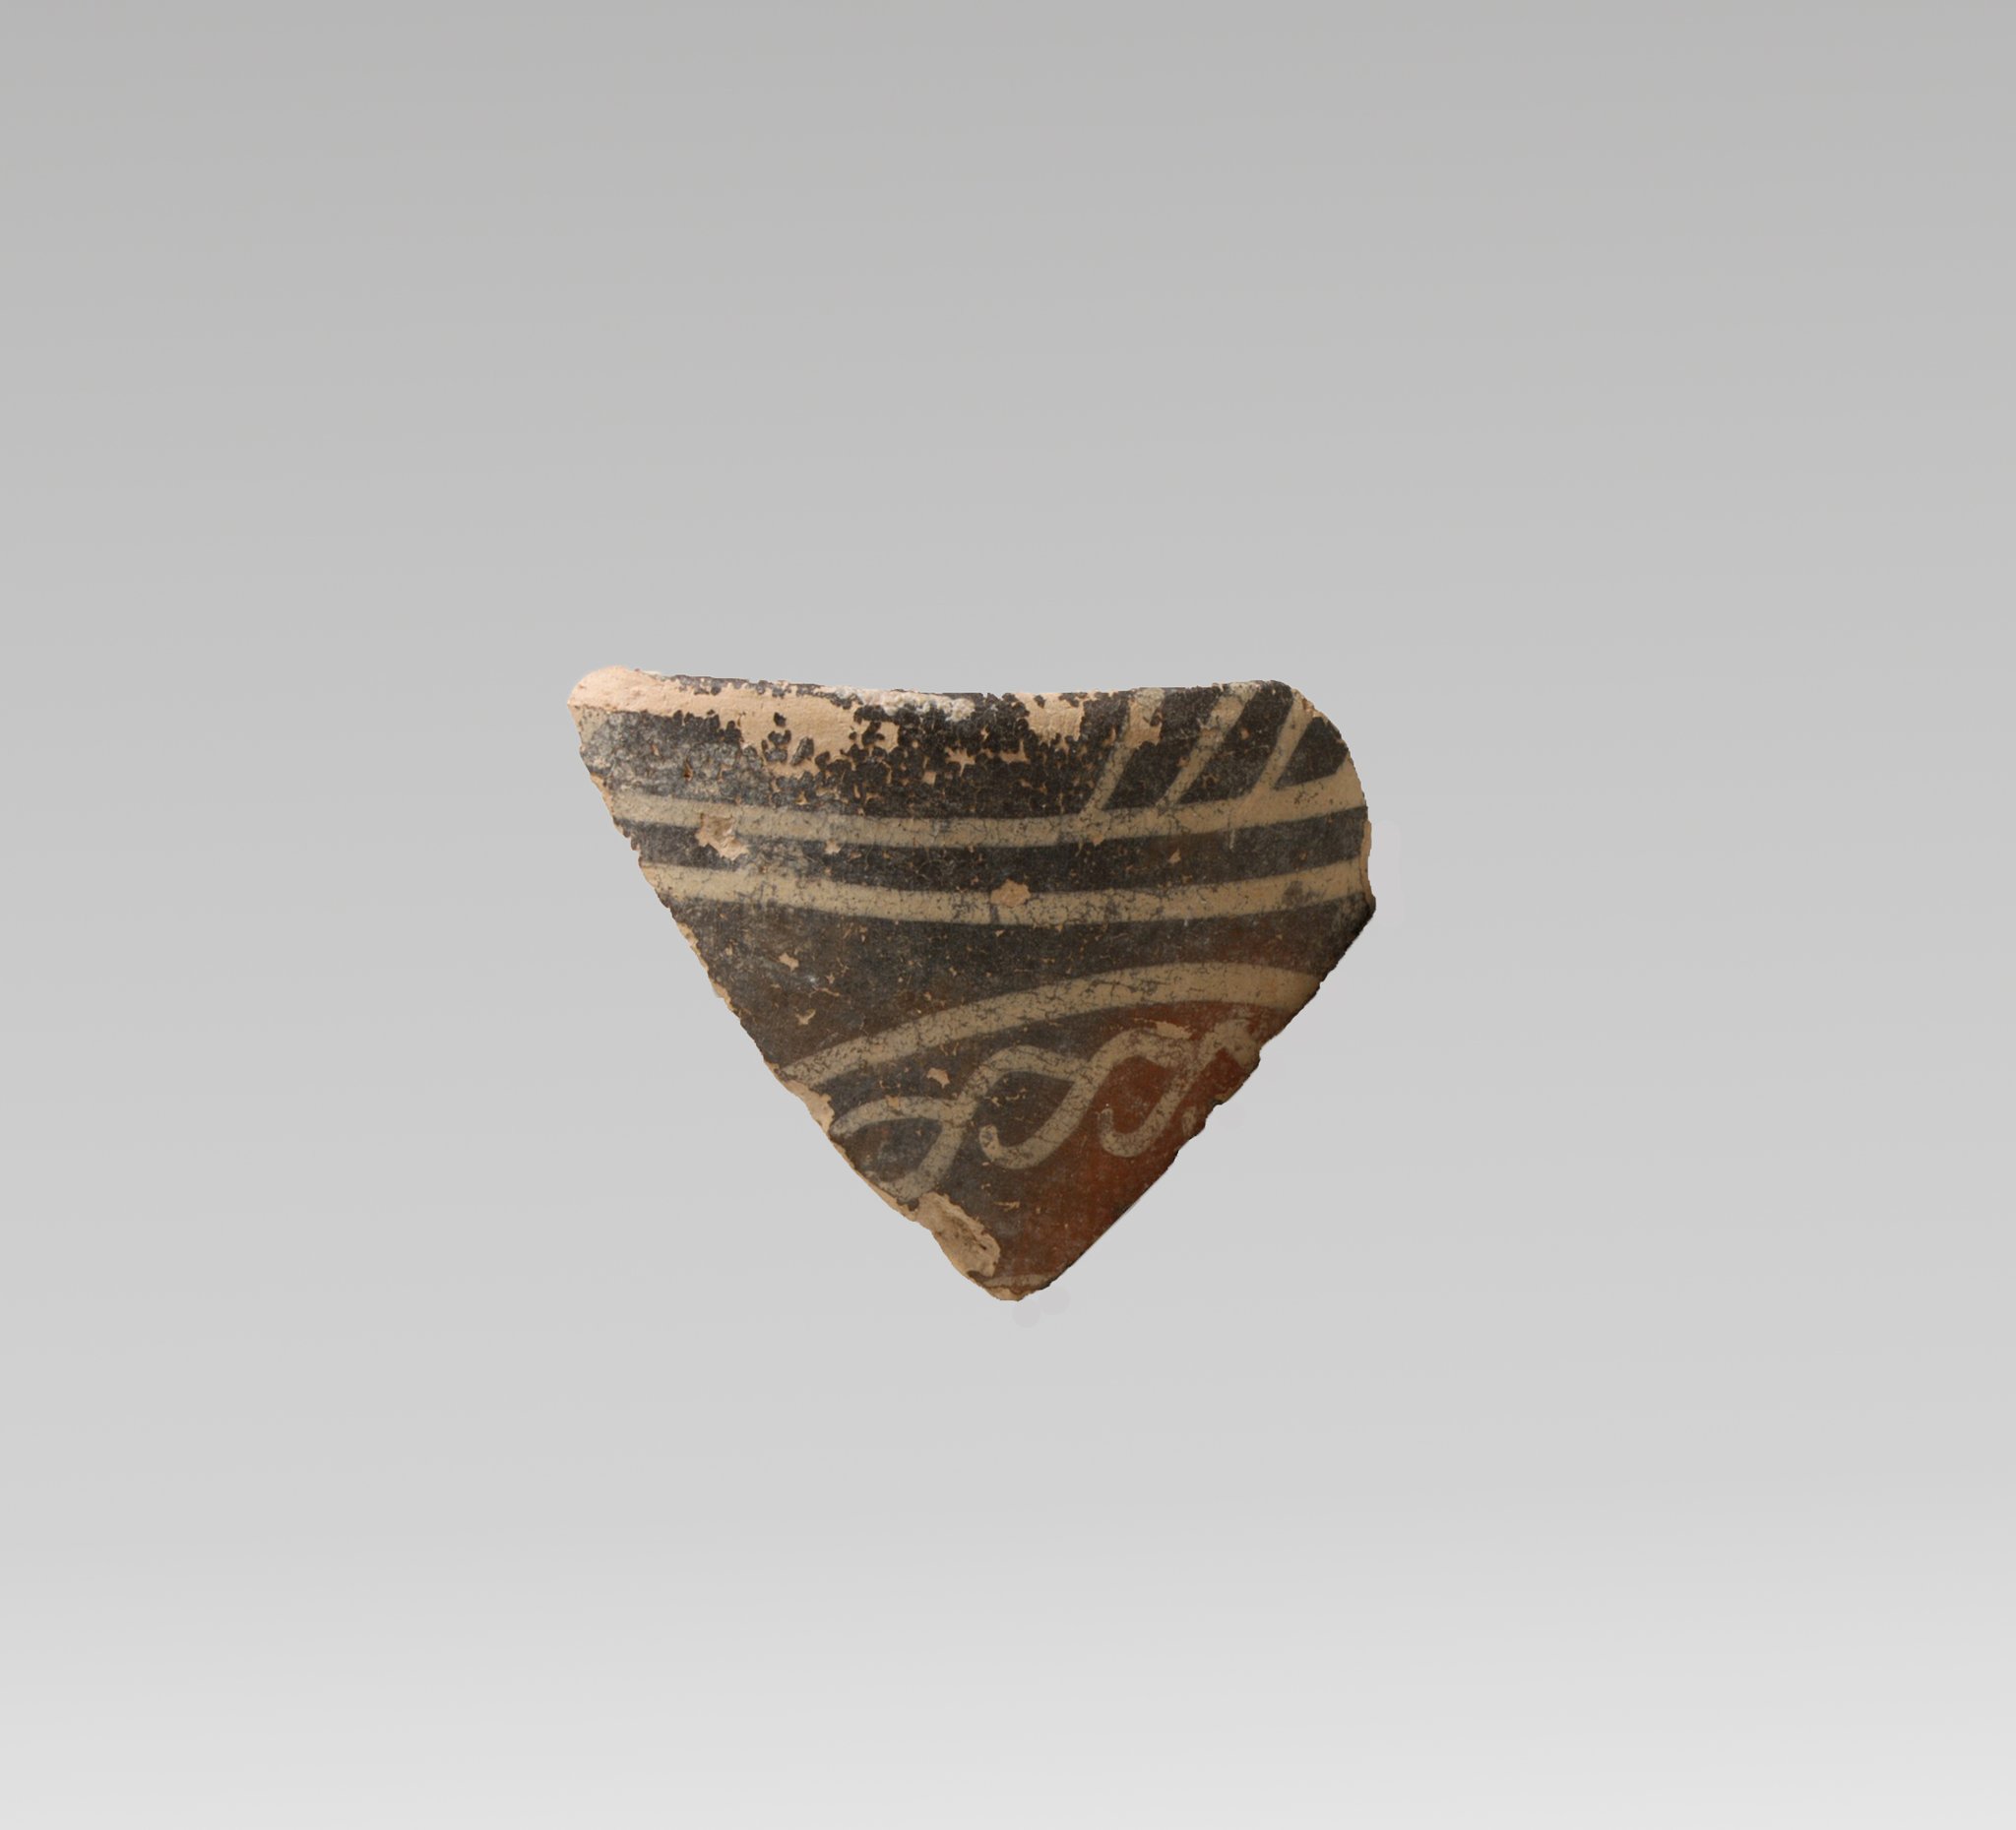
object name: vase fragment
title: Terracotta rim fragment with quirks and bands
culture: minoan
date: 2300-2100 BCE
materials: terracotta